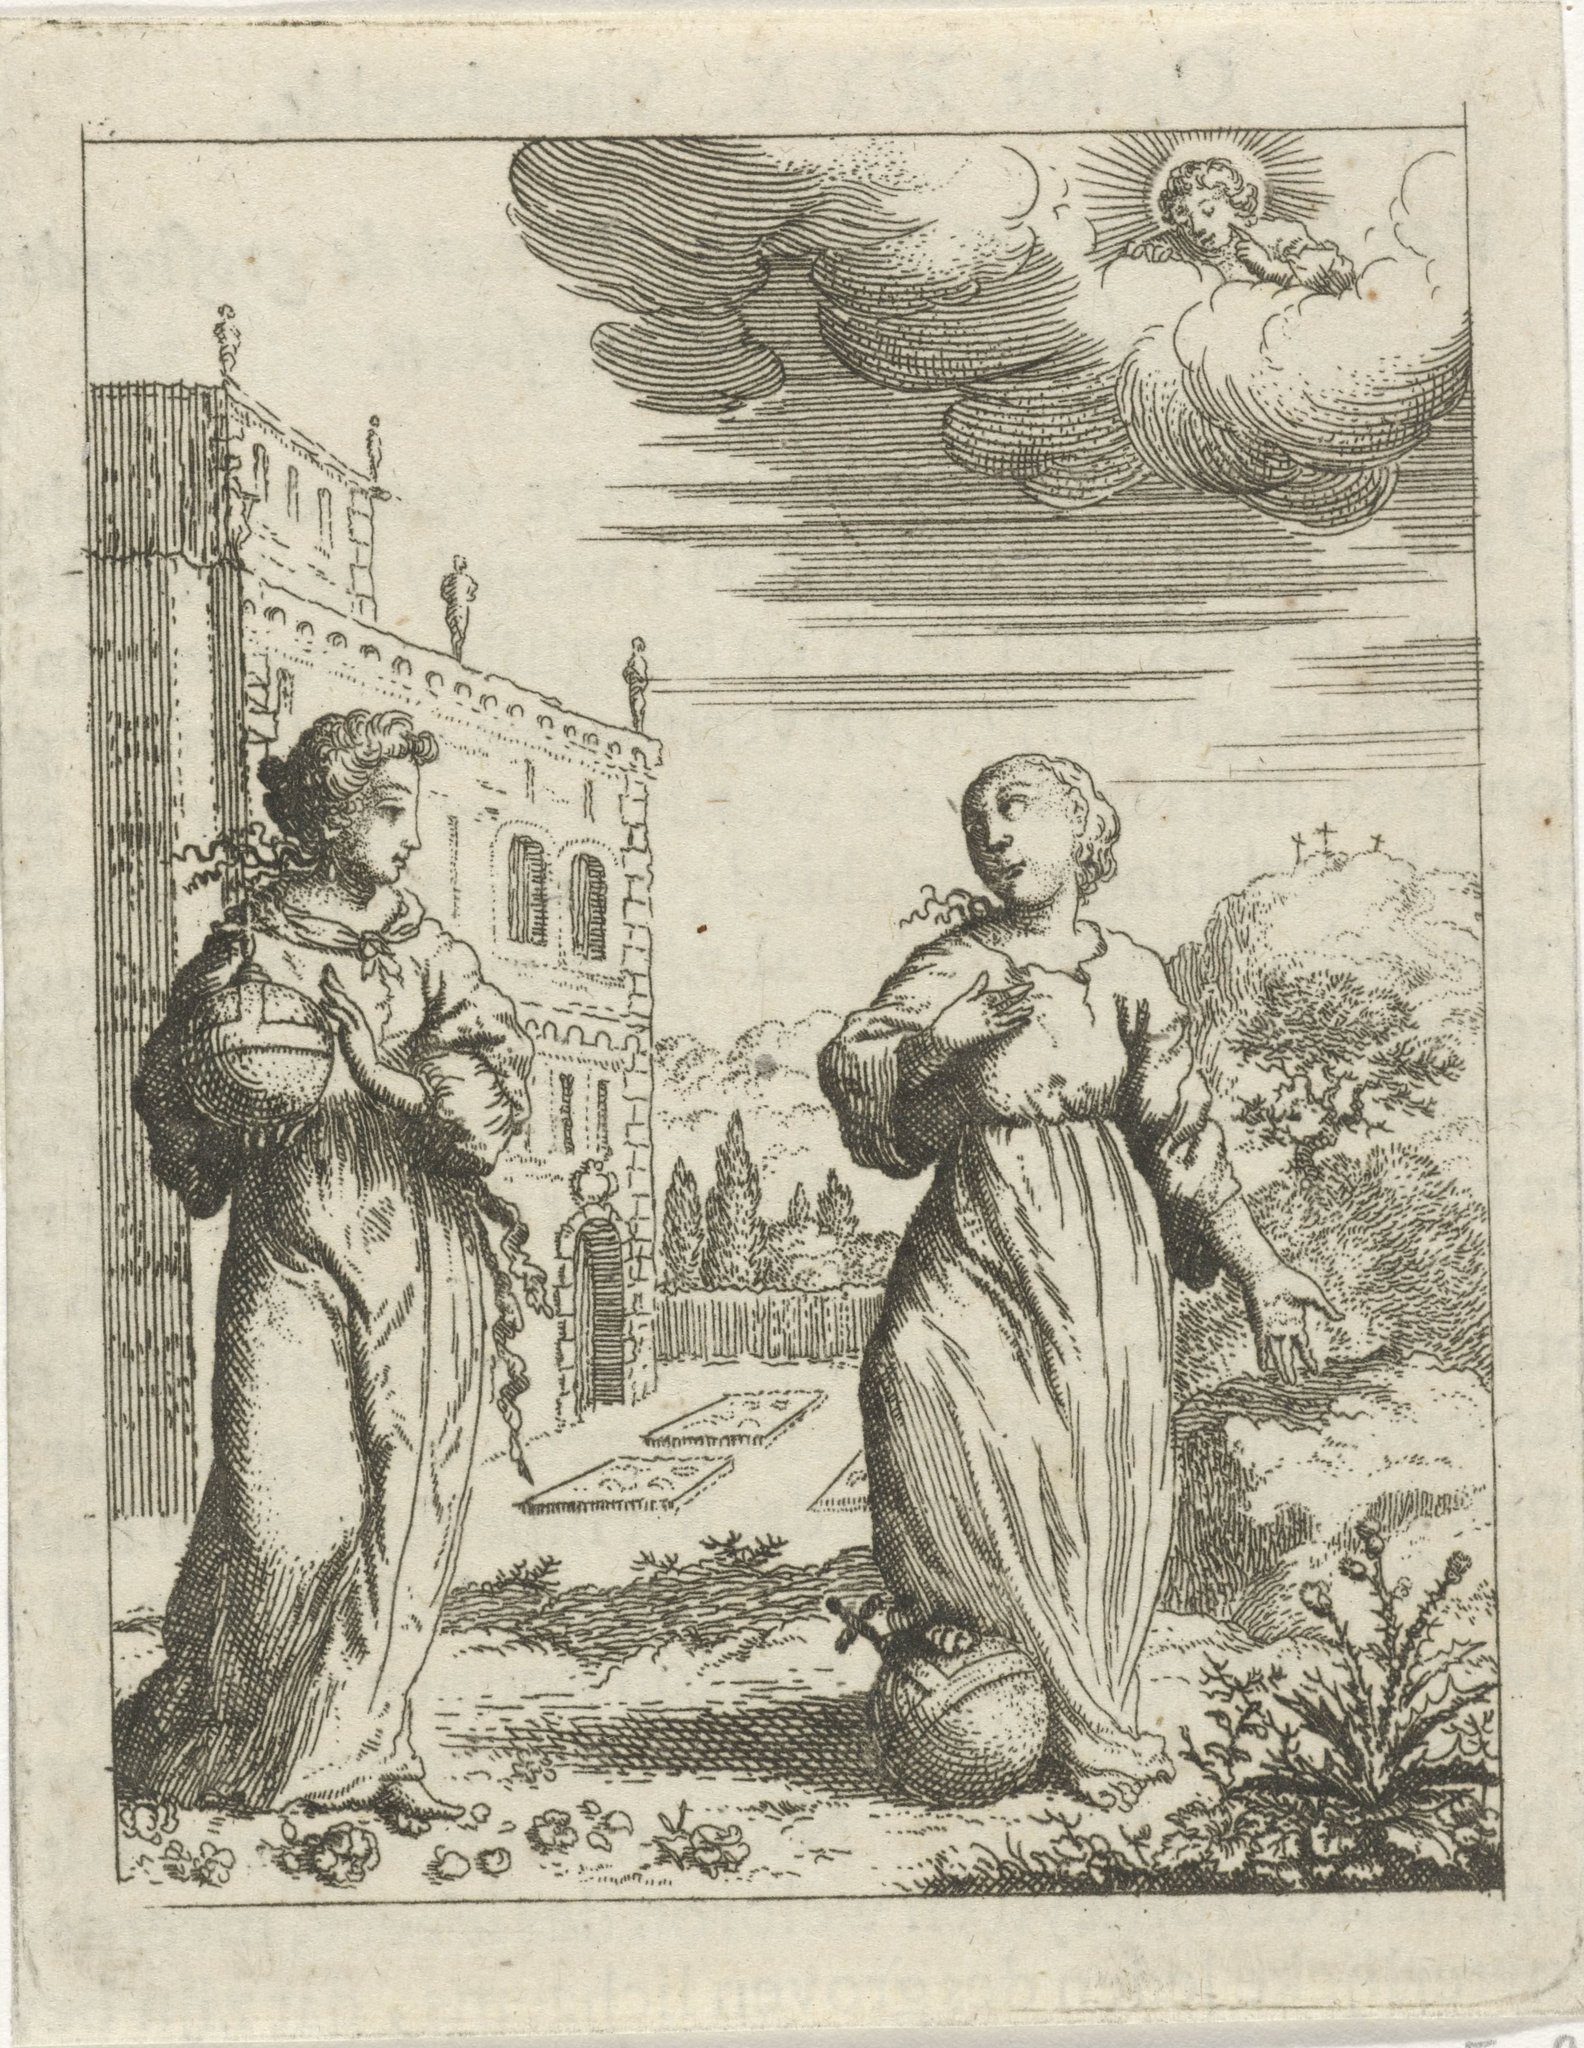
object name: book illustration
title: Vrouwe Wereld en de gepersonifieerde ziel die een rijksappel vertreedt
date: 1678-1687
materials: paper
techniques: etching, letterpress printing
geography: amsterdam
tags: the soul, 'frau welt'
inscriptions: collector's mark: Lugt 2228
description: Illustratie uit: Luyken, Jan. Jezus en de Ziel, 3 delen. Amsterdam: Pieter Arentsz II, 1678-1687. Tussen 1678-1744 verschenen van dit emblemataboek 10 edities.